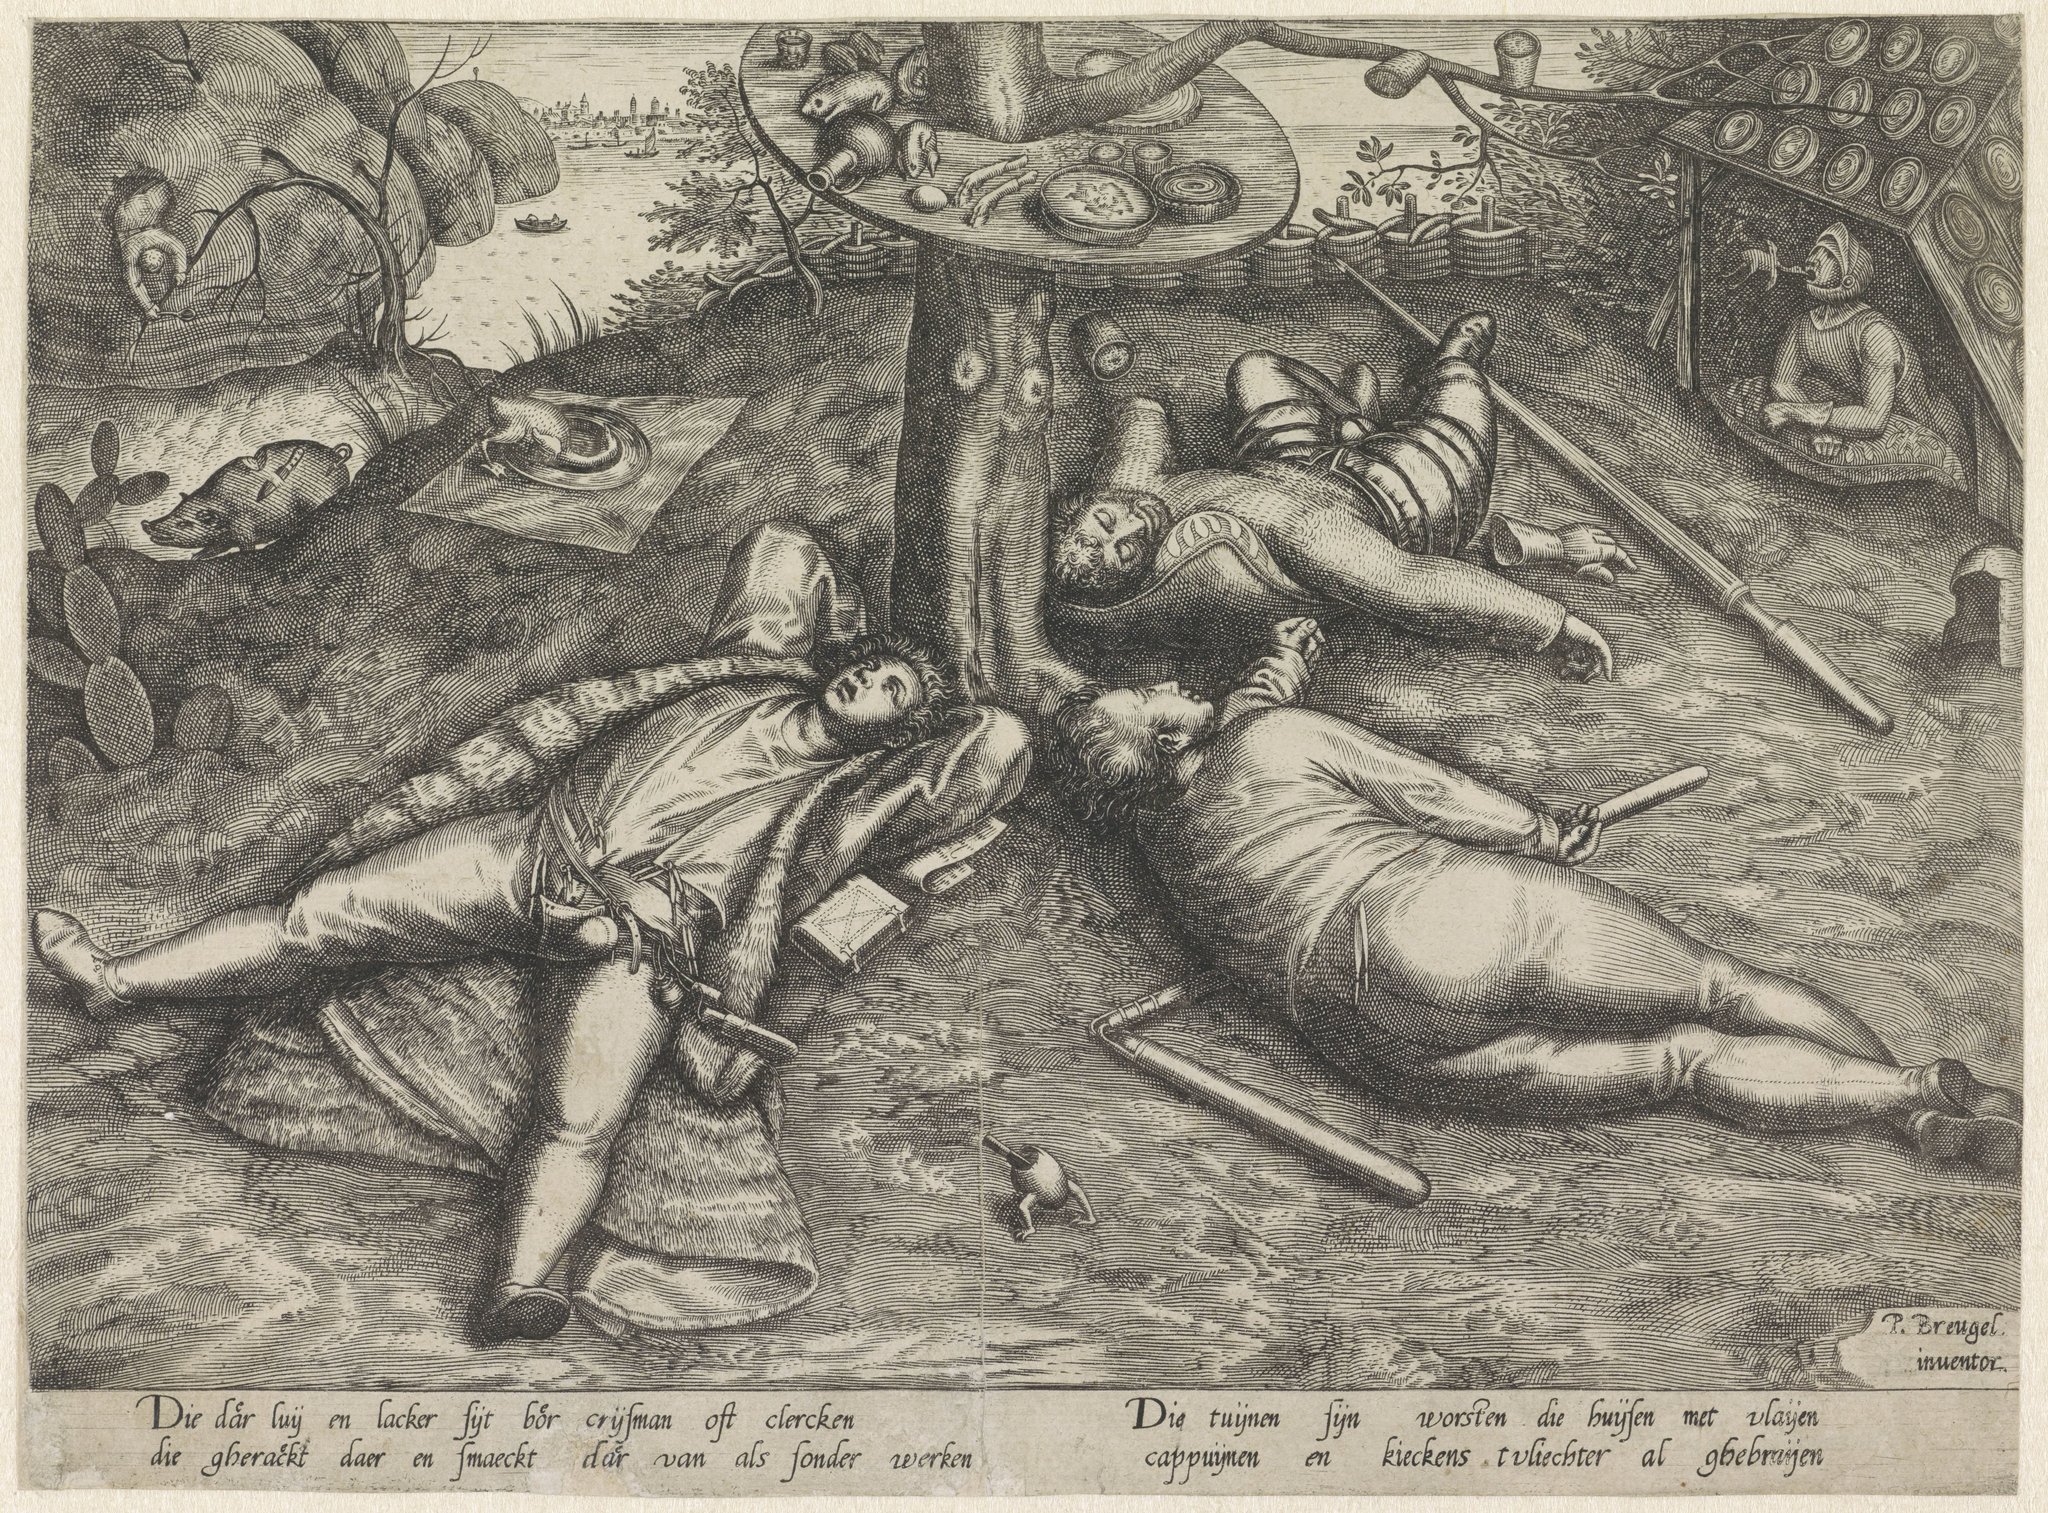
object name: print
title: Luilekkerland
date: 1567-1600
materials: paper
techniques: engraving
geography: netherlands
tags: land of cockaigne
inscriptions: collector's mark: Lugt 2228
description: Een klerk, een boer en een soldaat liggen in Luilekkerland op de grond te slapen rond een aan een boom bevestigde tafel, waarop verschillende lekkernijen liggen. Rechts op de achtergrond een vrouw met open mond, waarin een gebraden vogel vliegt. Onder de voorstelling twee tweeregelige verzen in het Nederlands.